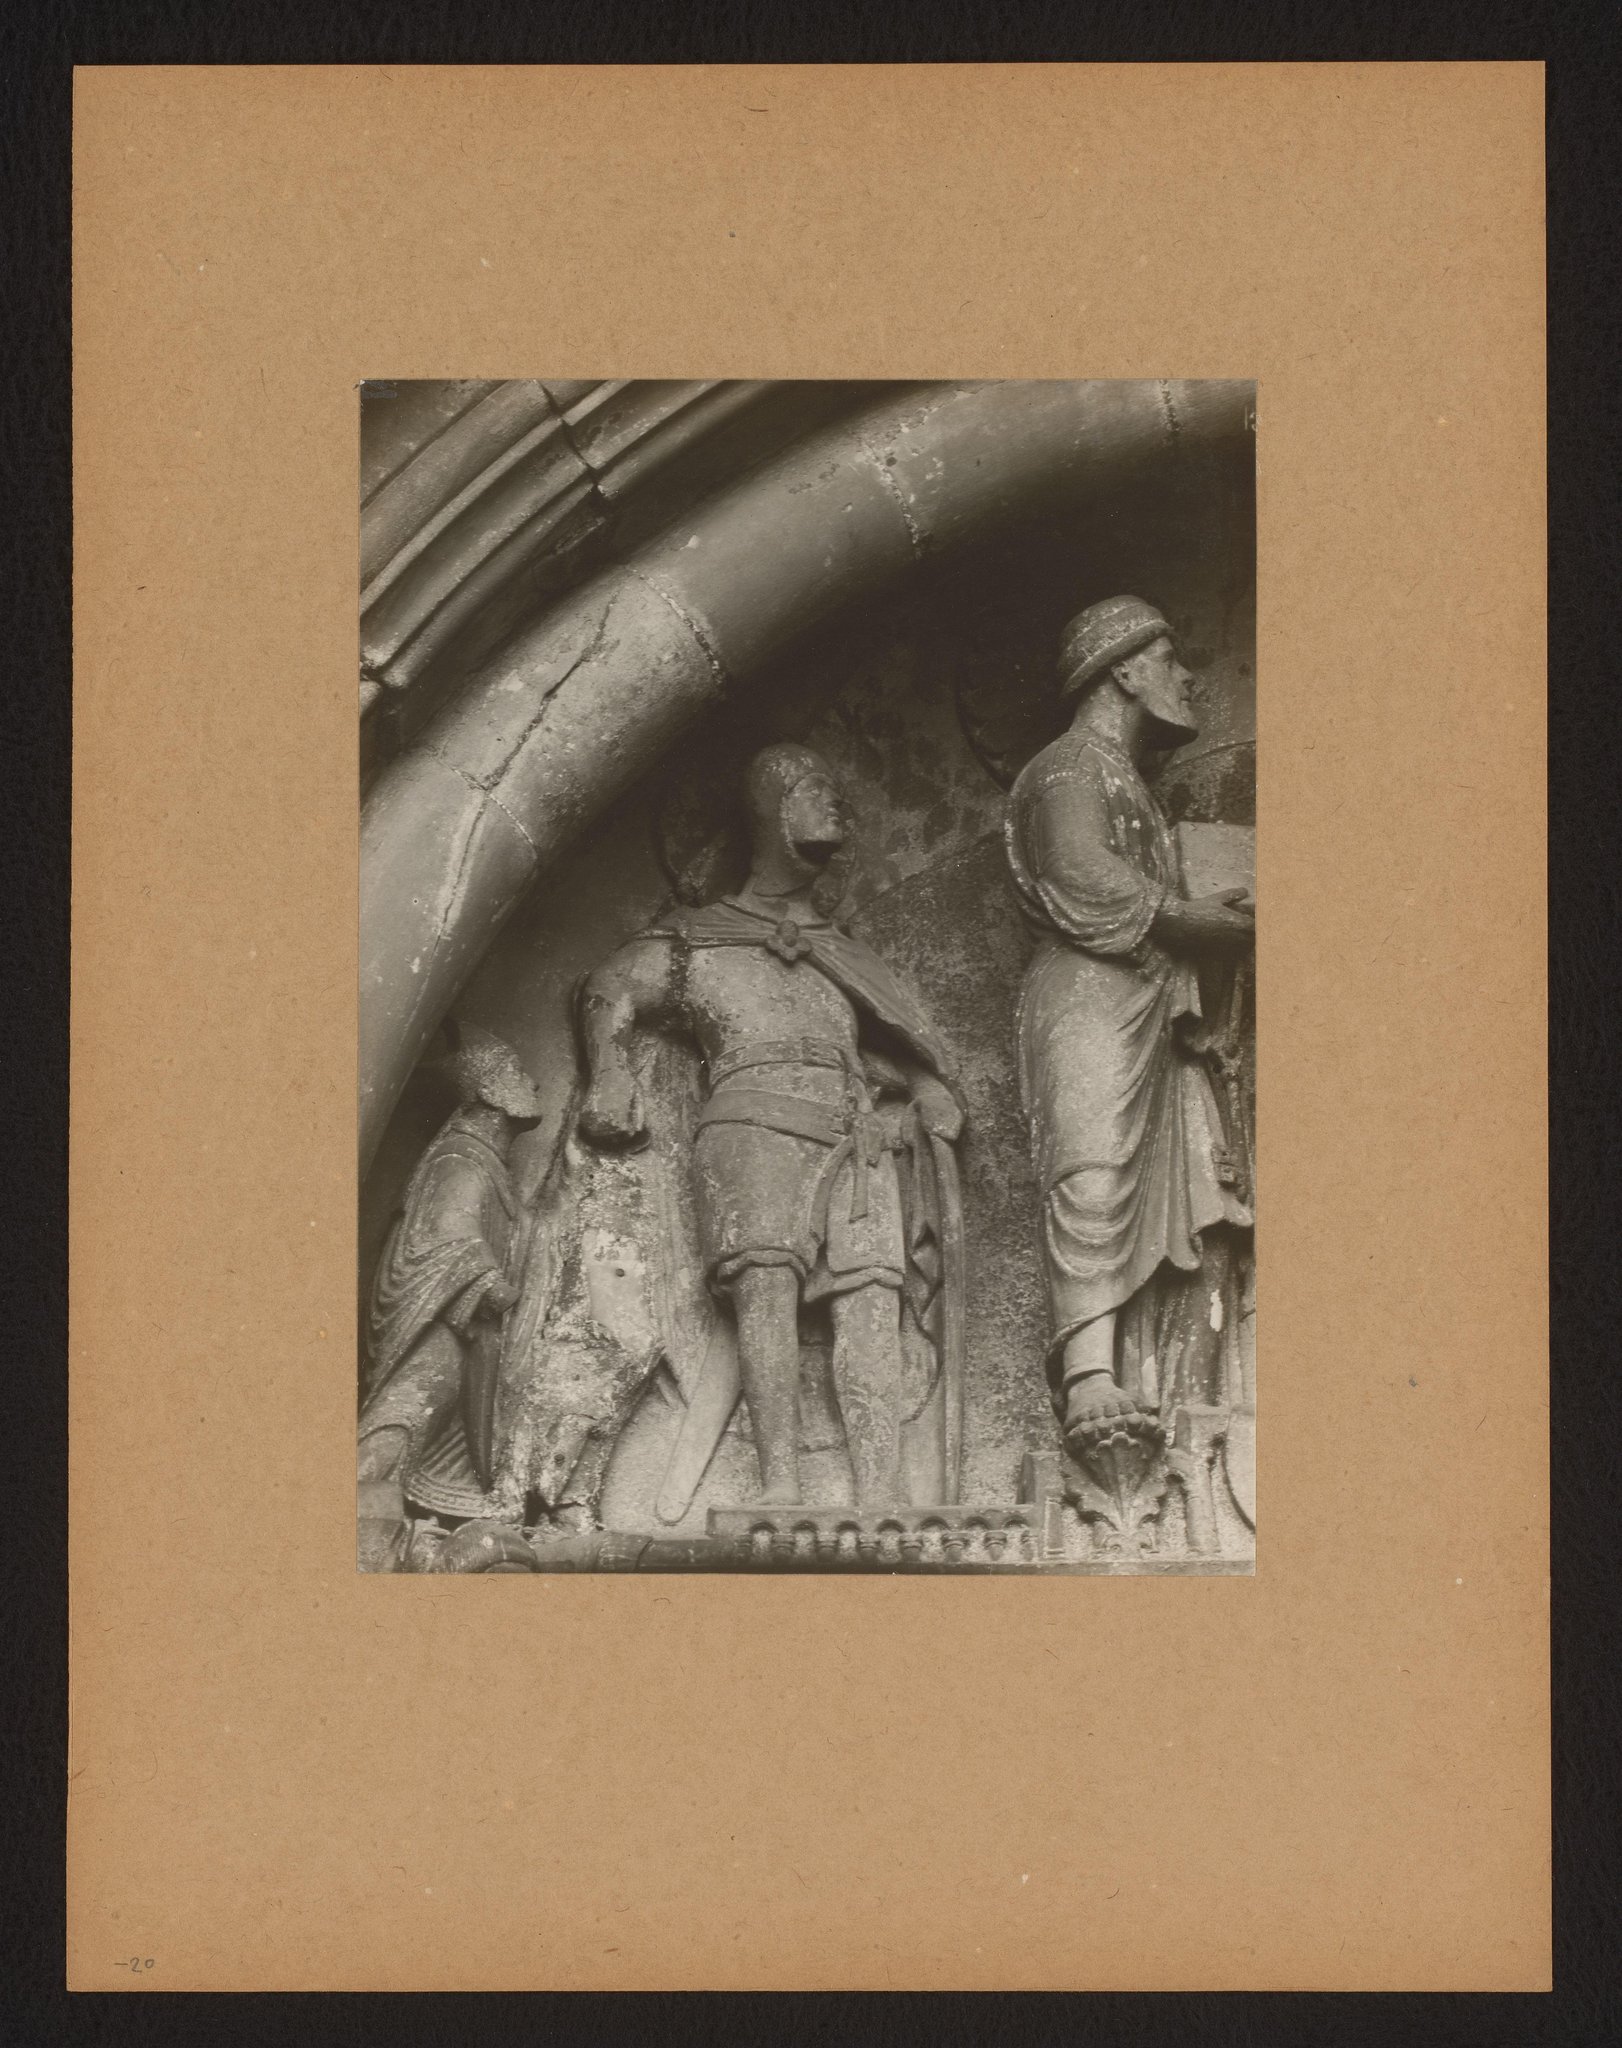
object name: album leaf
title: Marienpforte, li. Drittel v. vorn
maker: Anonymous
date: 1900-1920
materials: paper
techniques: gelatin silver print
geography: bamberg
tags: church (exterior)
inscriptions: number: ‘20.’